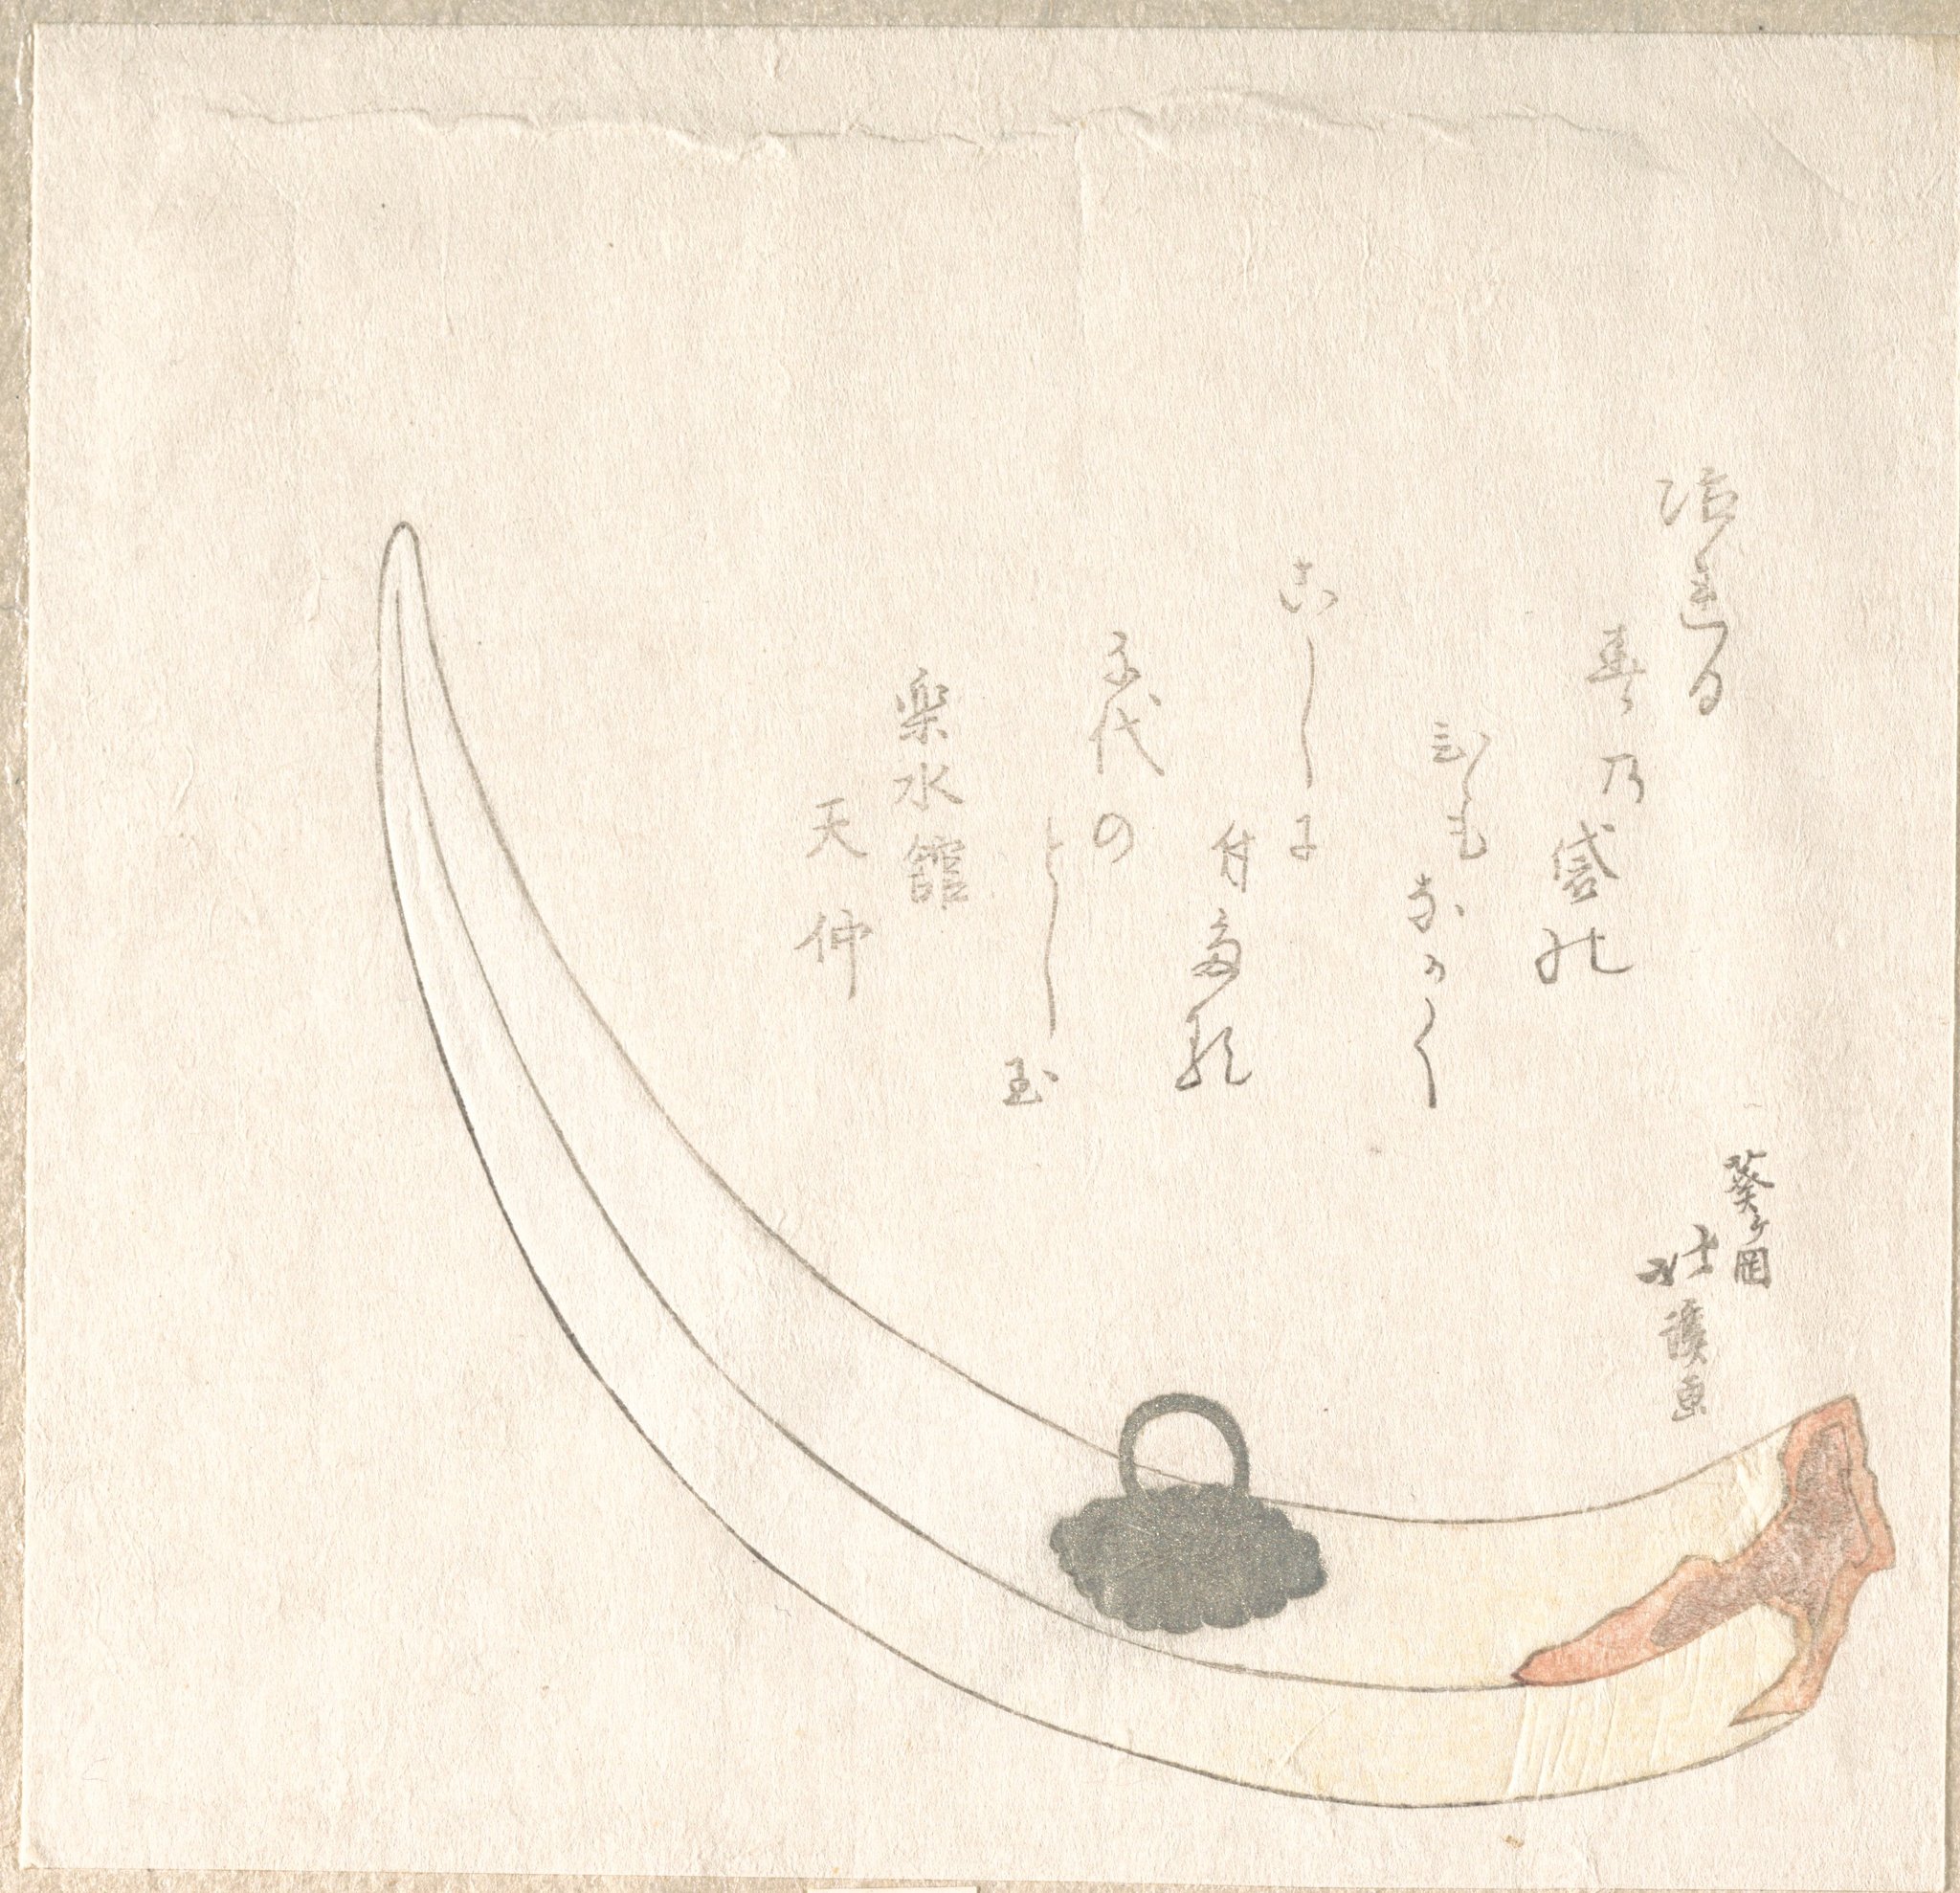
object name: print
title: Horn Flower-Vase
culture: japanese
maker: totoya hokkei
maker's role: artist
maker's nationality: japanese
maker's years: 1780-1850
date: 1801-1900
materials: ink, paper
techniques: surimono, woodblock print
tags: vases